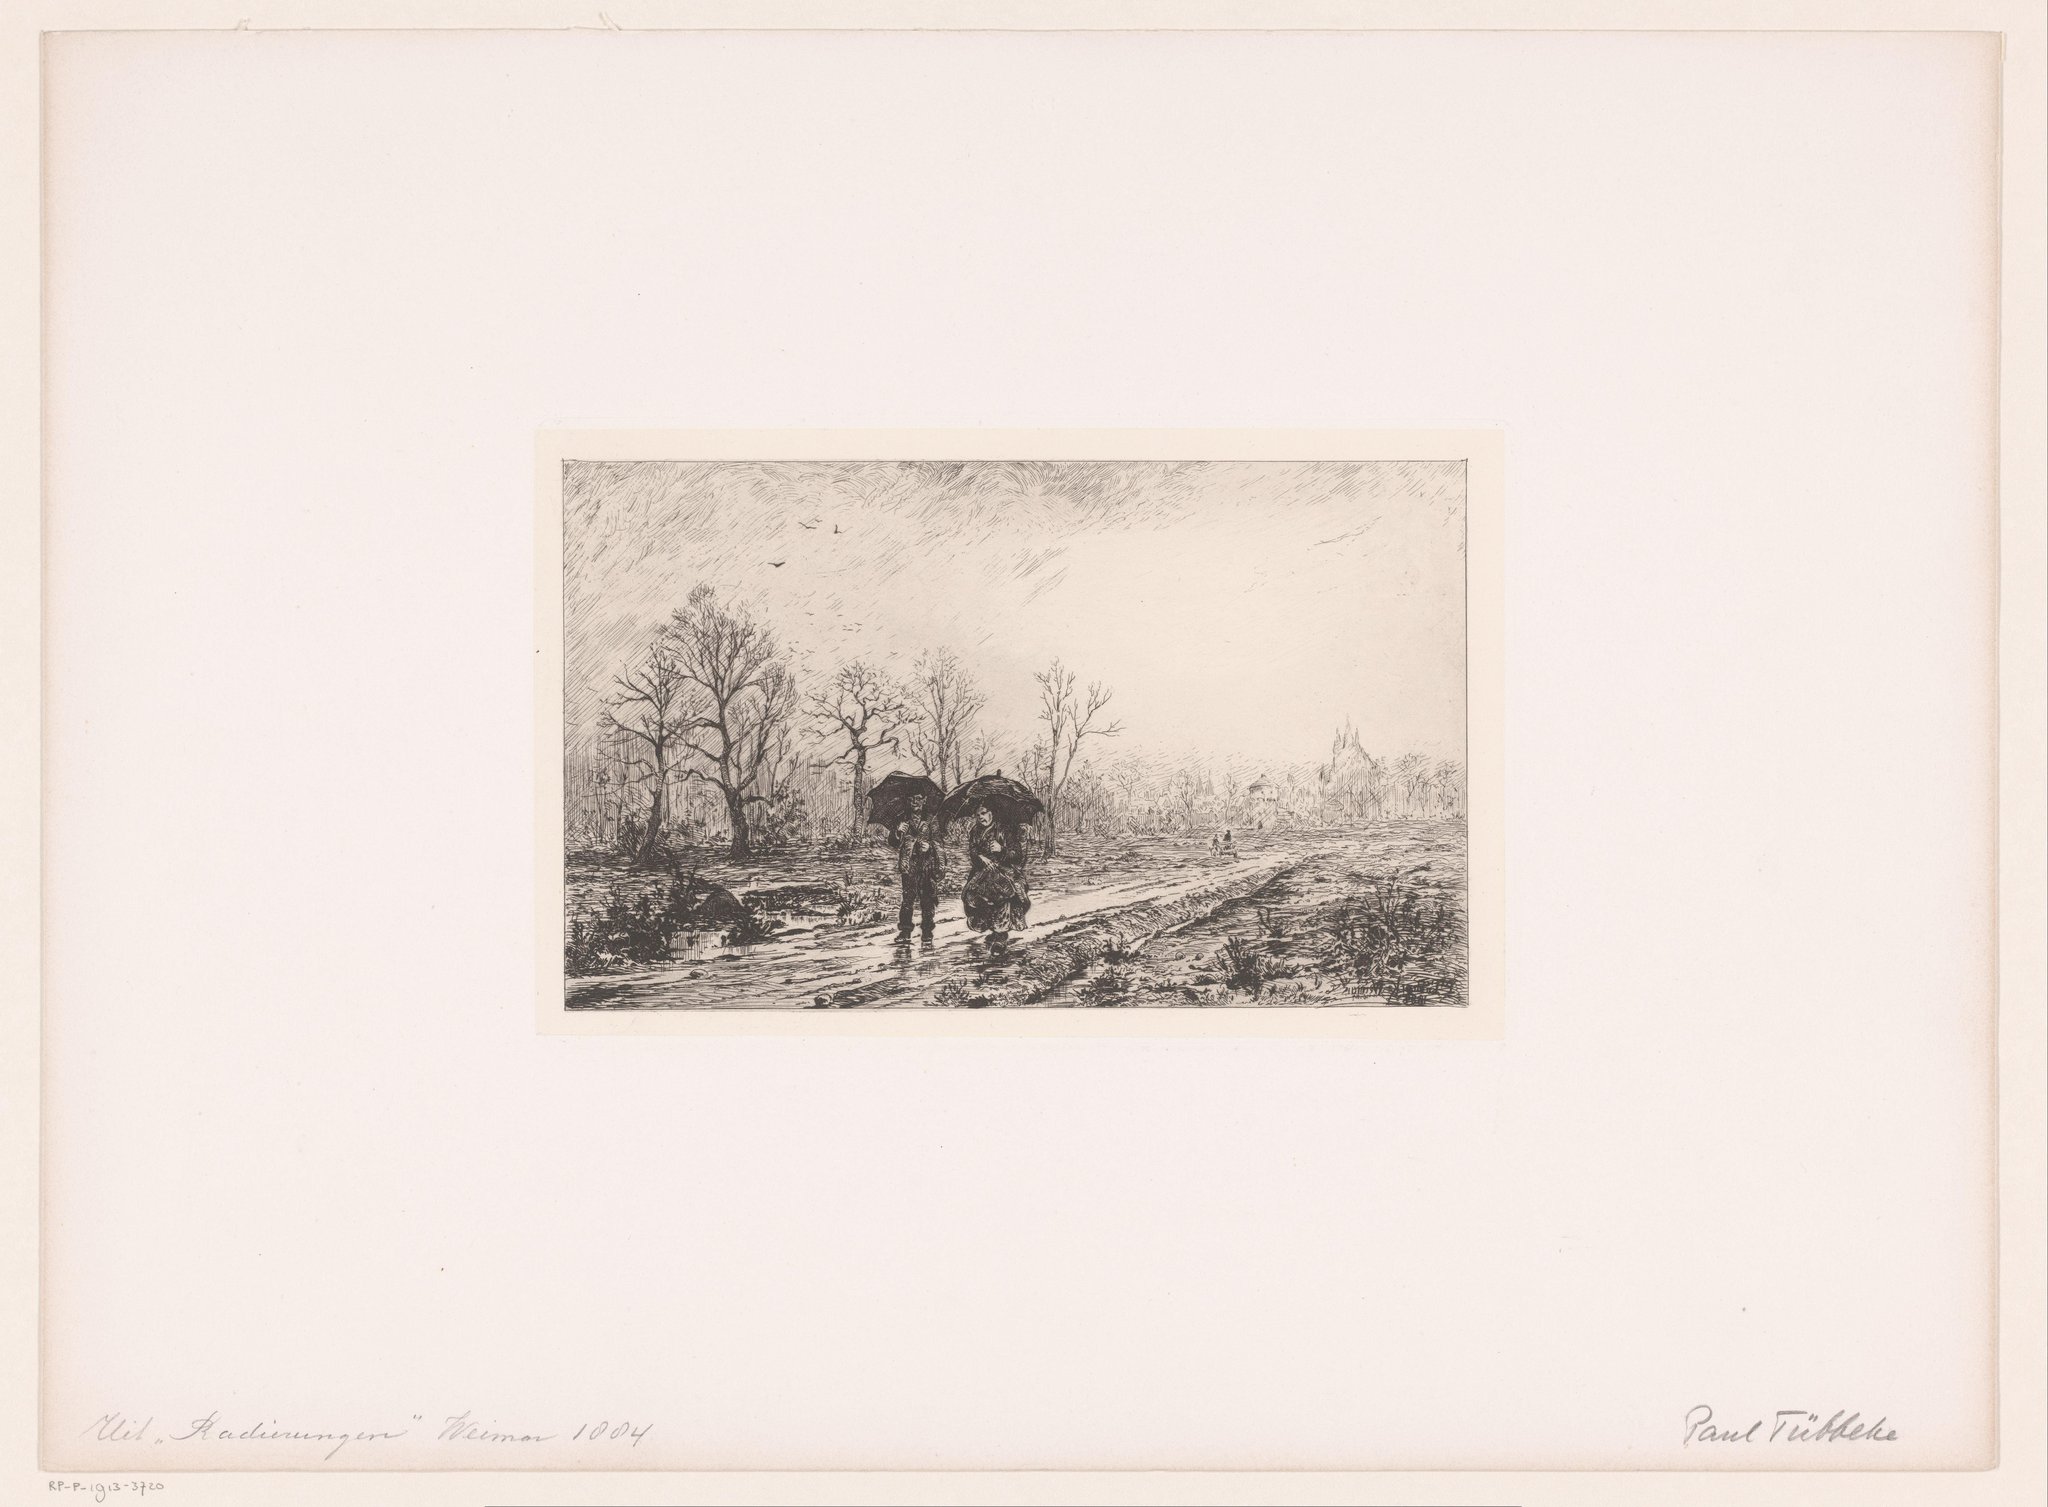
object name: print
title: Man en vrouw op een pad met paraplu's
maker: paul wilhelm tübbecke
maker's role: painter, print maker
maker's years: 1848-1924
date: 1884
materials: paper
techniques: etching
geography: weimar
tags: rain, umbrella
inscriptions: inscription: ‘Uit "Radierungen" Weimar 1884’, collector's mark: Lugt 2228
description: Prent maakt deel uit van een groep prenten die tussen 1880 en 1888 werd uitgegeven door het Gesellschaft für Radierkunst te Weimar.